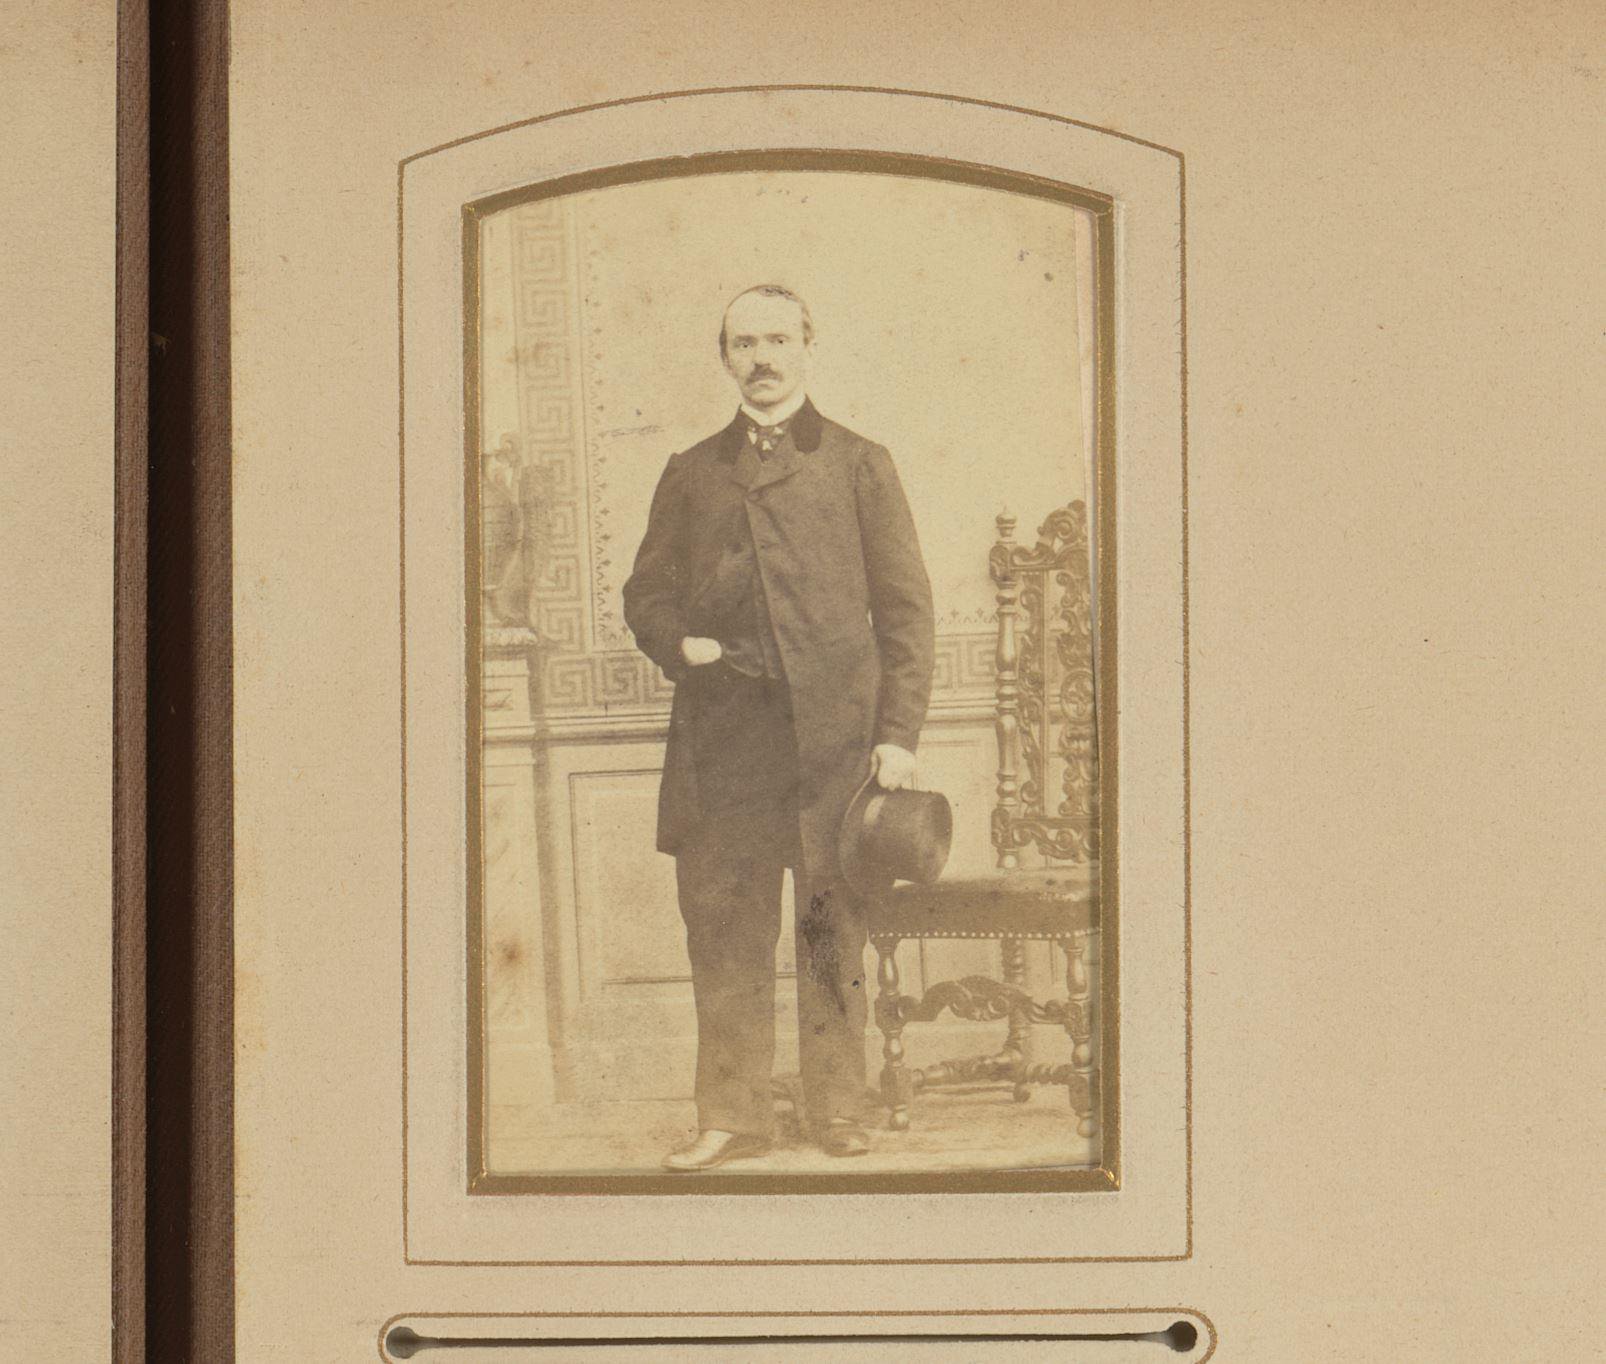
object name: photograph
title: Portret van een staande man met hoge hoed in de hand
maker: henri blanckart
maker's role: fotograaf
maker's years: 1833-1894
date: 1865-1870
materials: cardboard, photographic support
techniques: albumen print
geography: saint-trond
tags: standing figure, historical persons, head-gear: top hat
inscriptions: annotation: ‘H Blanckart phot./ à St Trond’